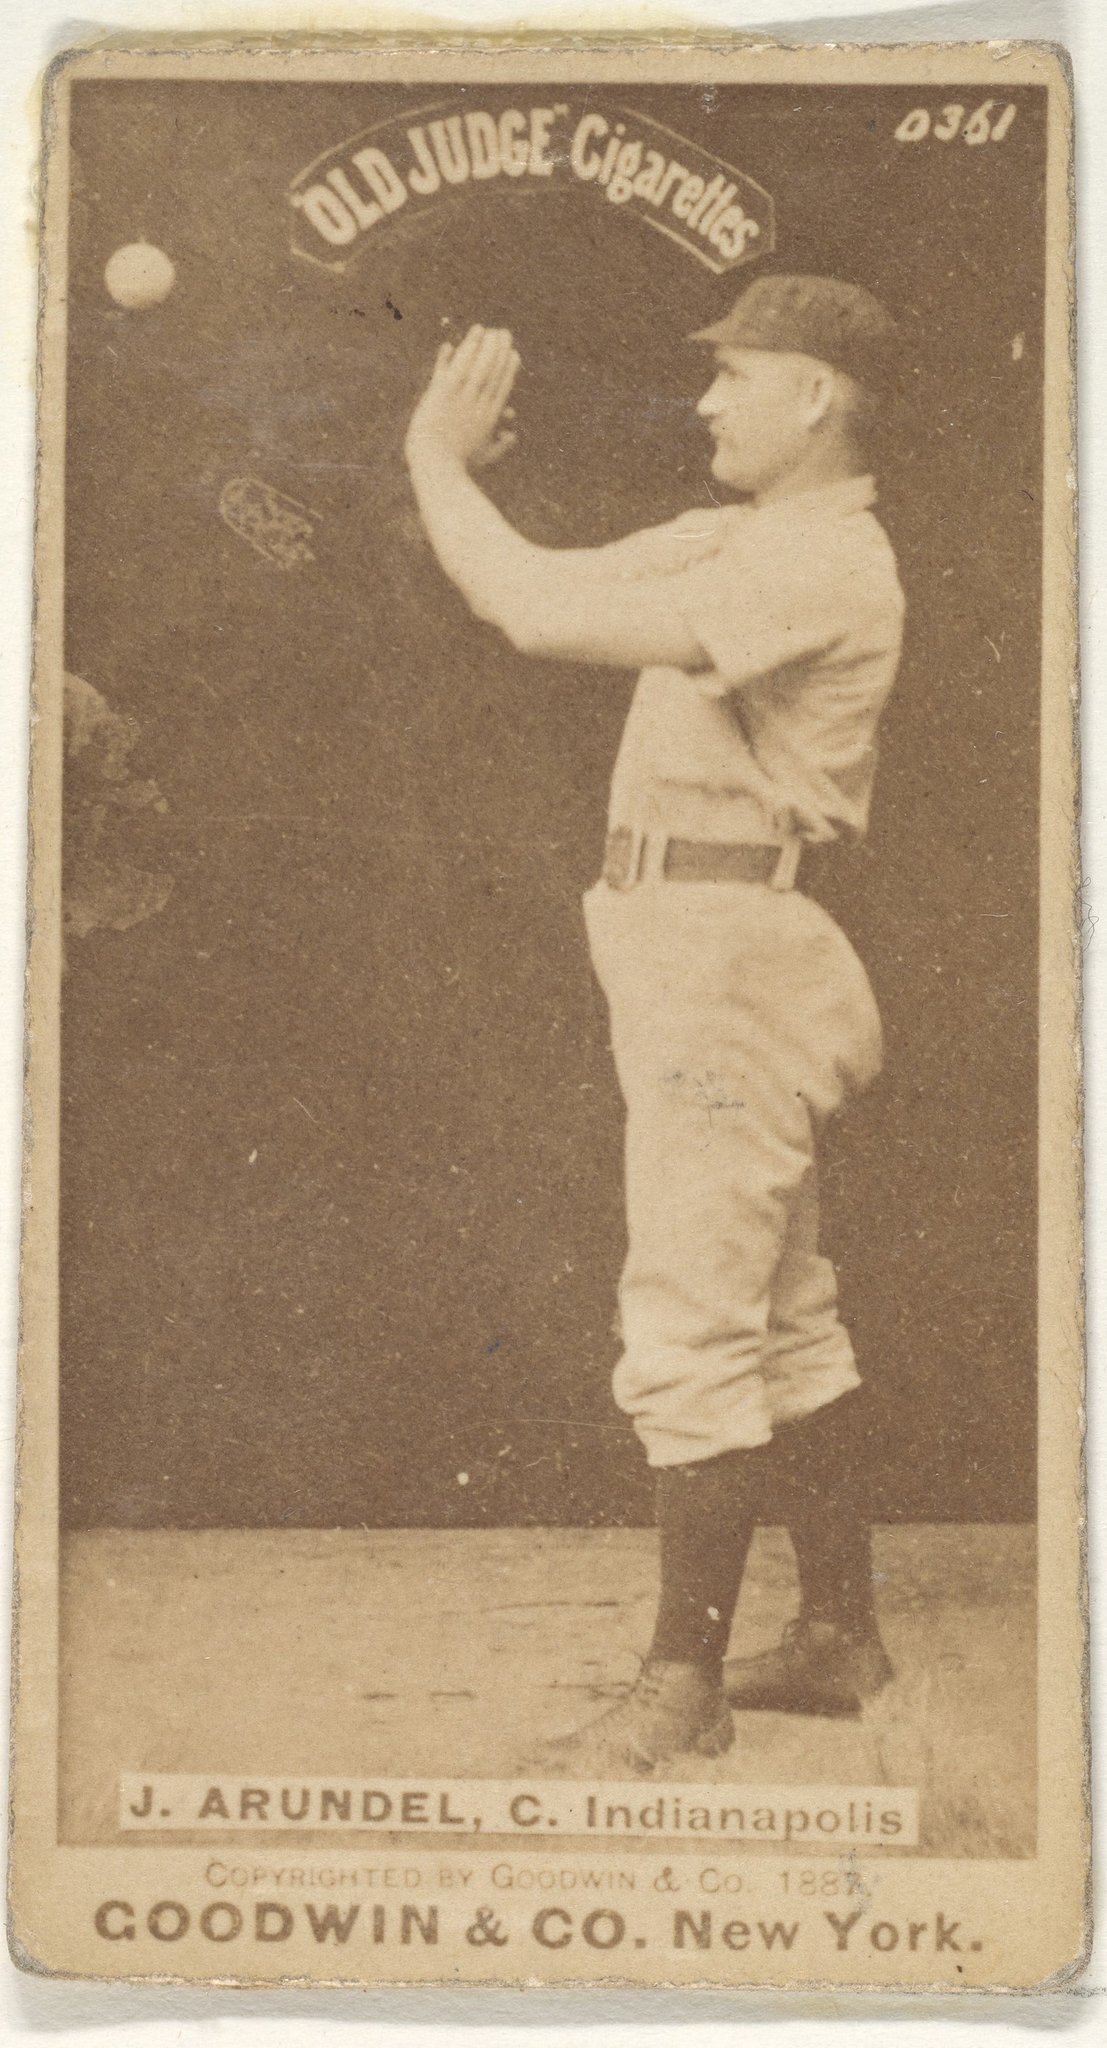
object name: baseball card, photograph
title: J. Arundel, Catcher, Indianapolis, from the Old Judge series (N172) for Old Judge Cigarettes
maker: goodwin & company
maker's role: publisher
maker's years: 1850-1950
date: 1887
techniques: albumen silver print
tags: men,portraits,baseball,athletes